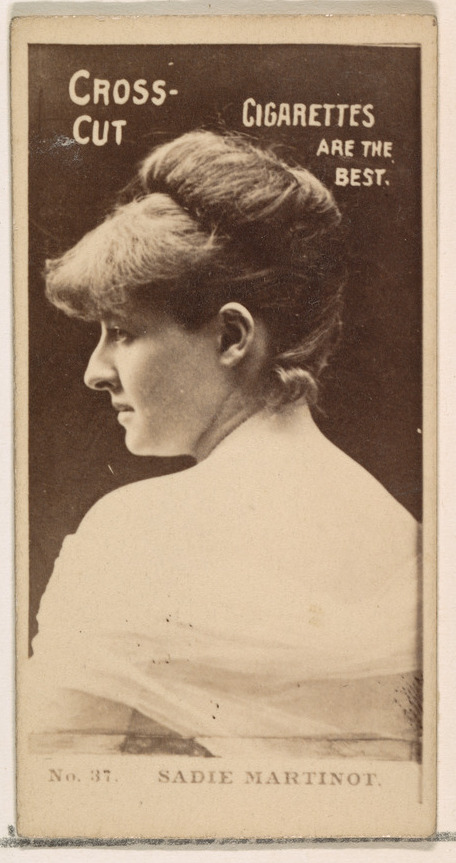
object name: print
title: Card Number 37, Miss Sadie Martinot, from the Actors and Actresses series (N145-2) issued by Duke Sons & Co. to promote Cross Cut Cigarettes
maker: w. duke, sons & co.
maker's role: publisher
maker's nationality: american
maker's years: 1870-1920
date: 1880-1889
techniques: albumen silver print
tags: women,actresses